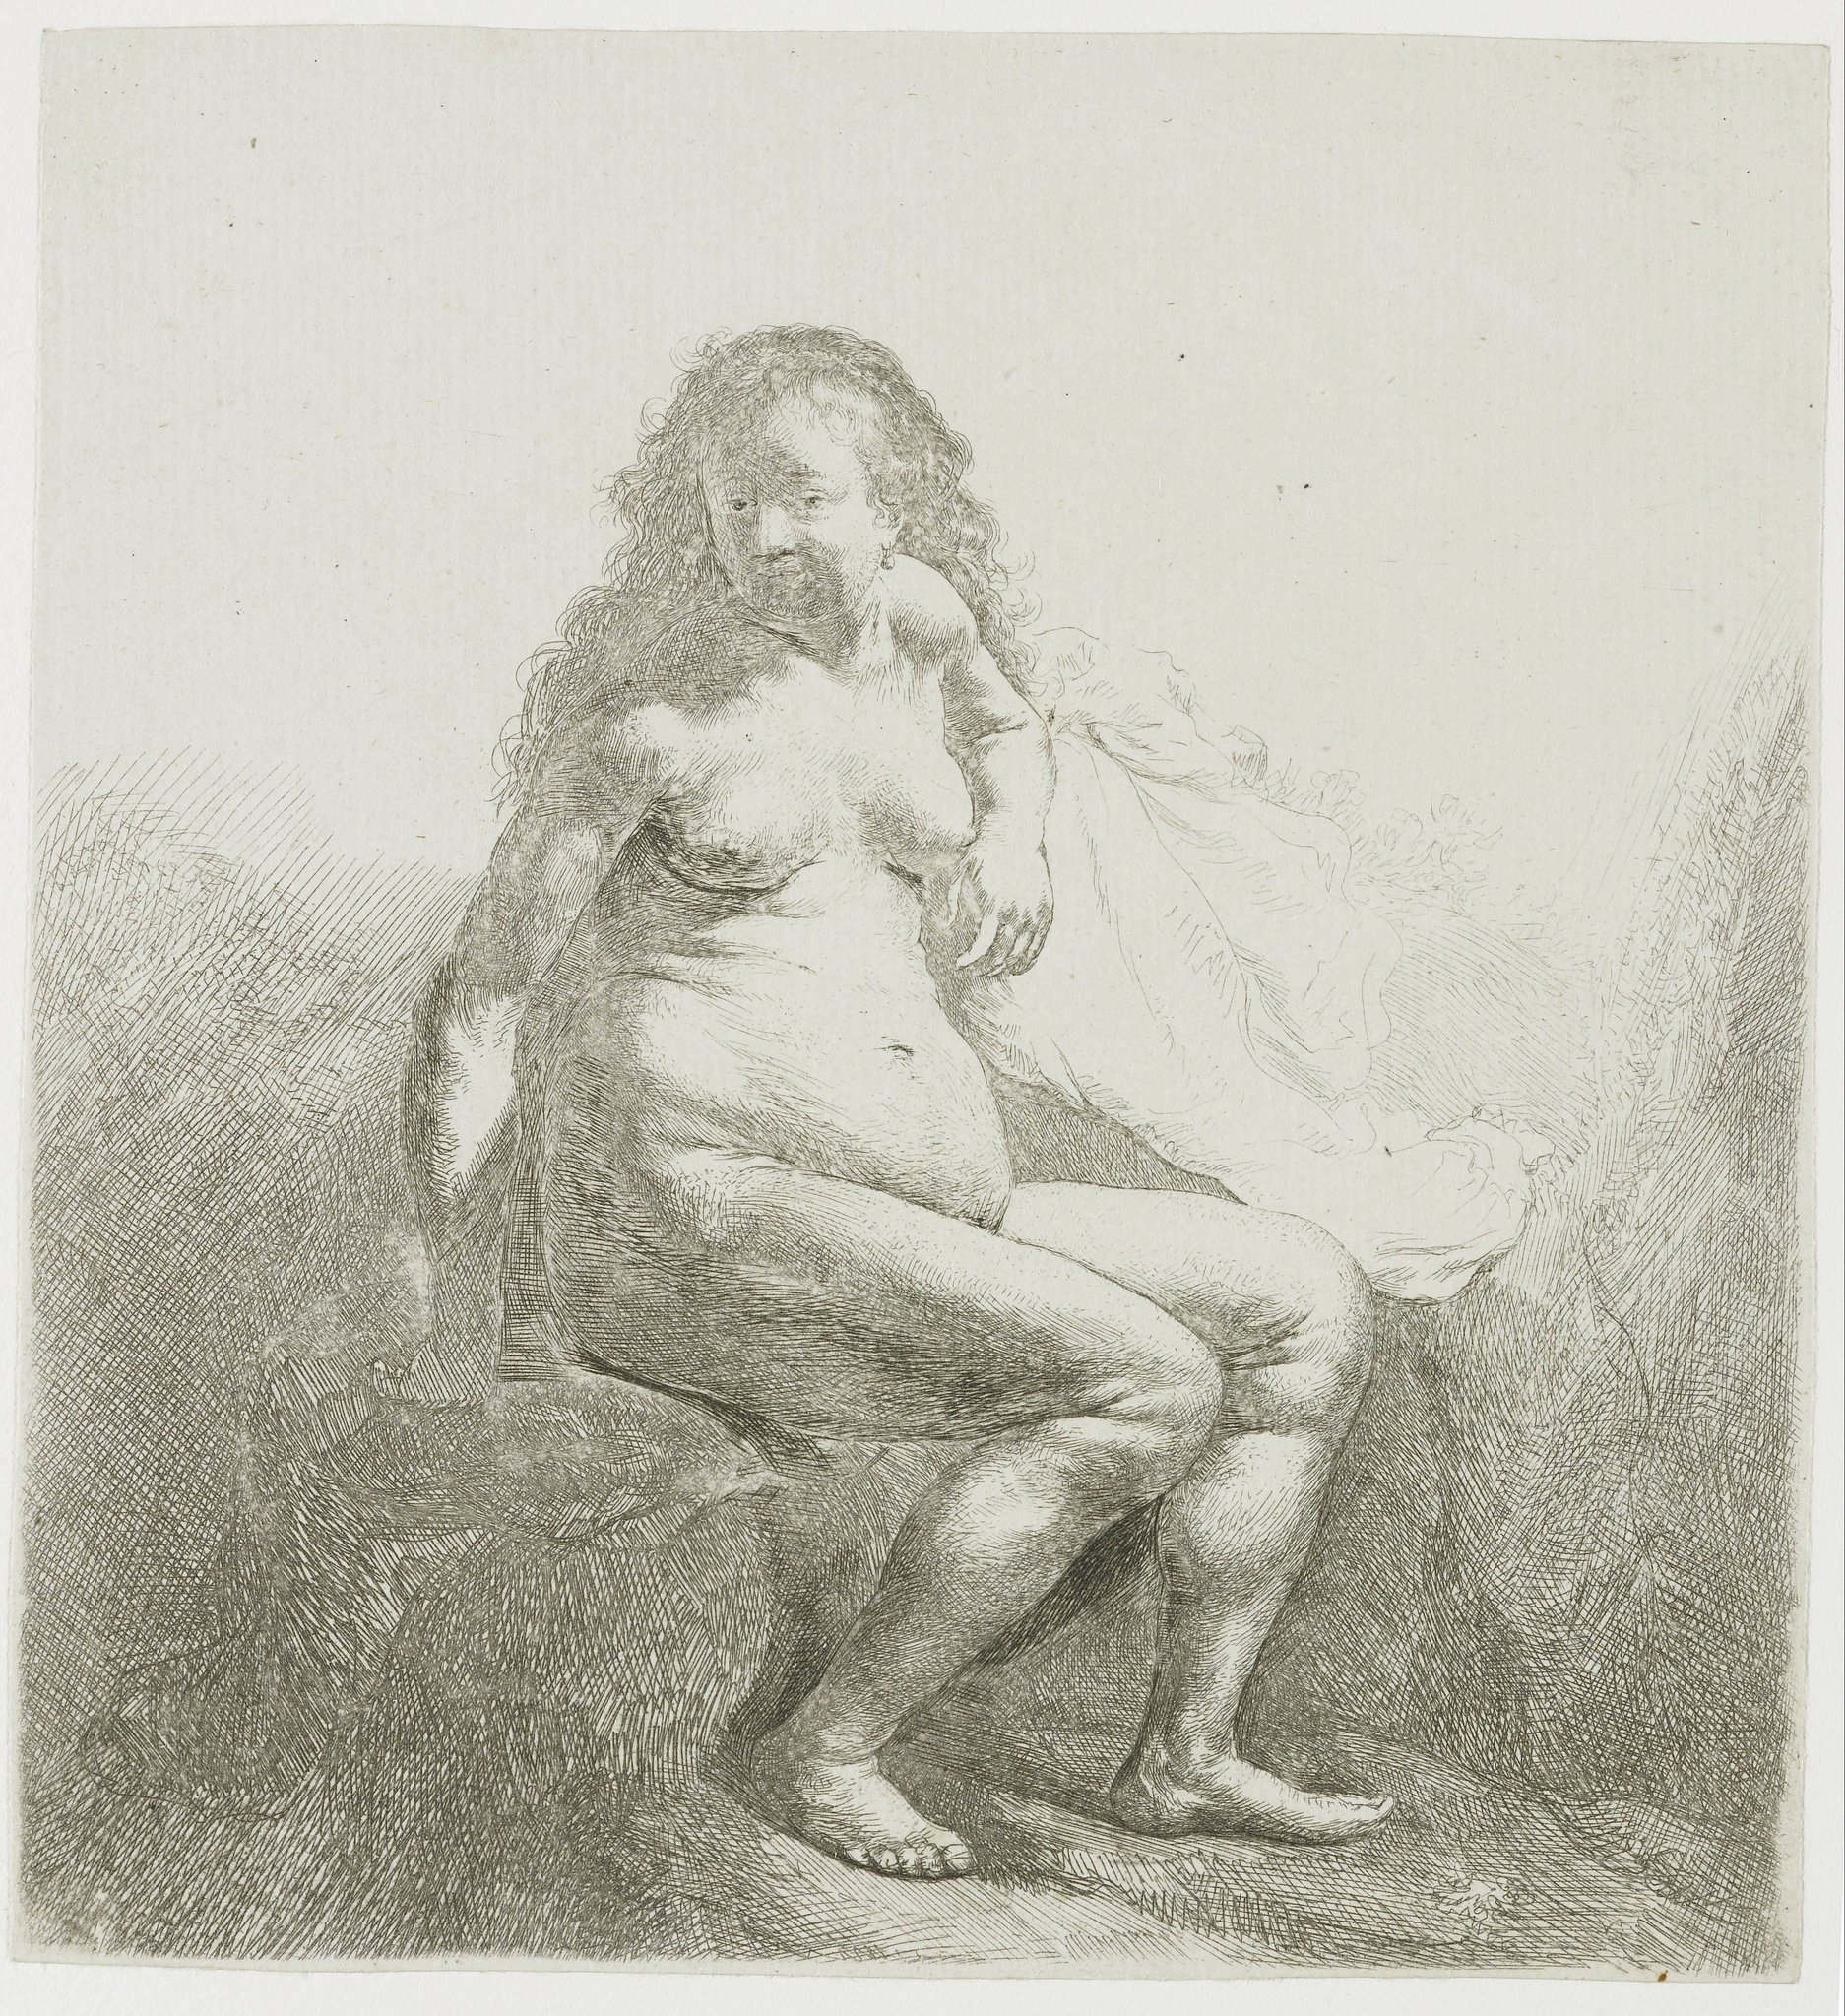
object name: print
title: Naked woman on a mound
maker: rembrandt van rijn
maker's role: draughtsman, painter, print maker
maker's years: 1606-1669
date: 1631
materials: paper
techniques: etching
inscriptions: collector's mark: Lugt 2165